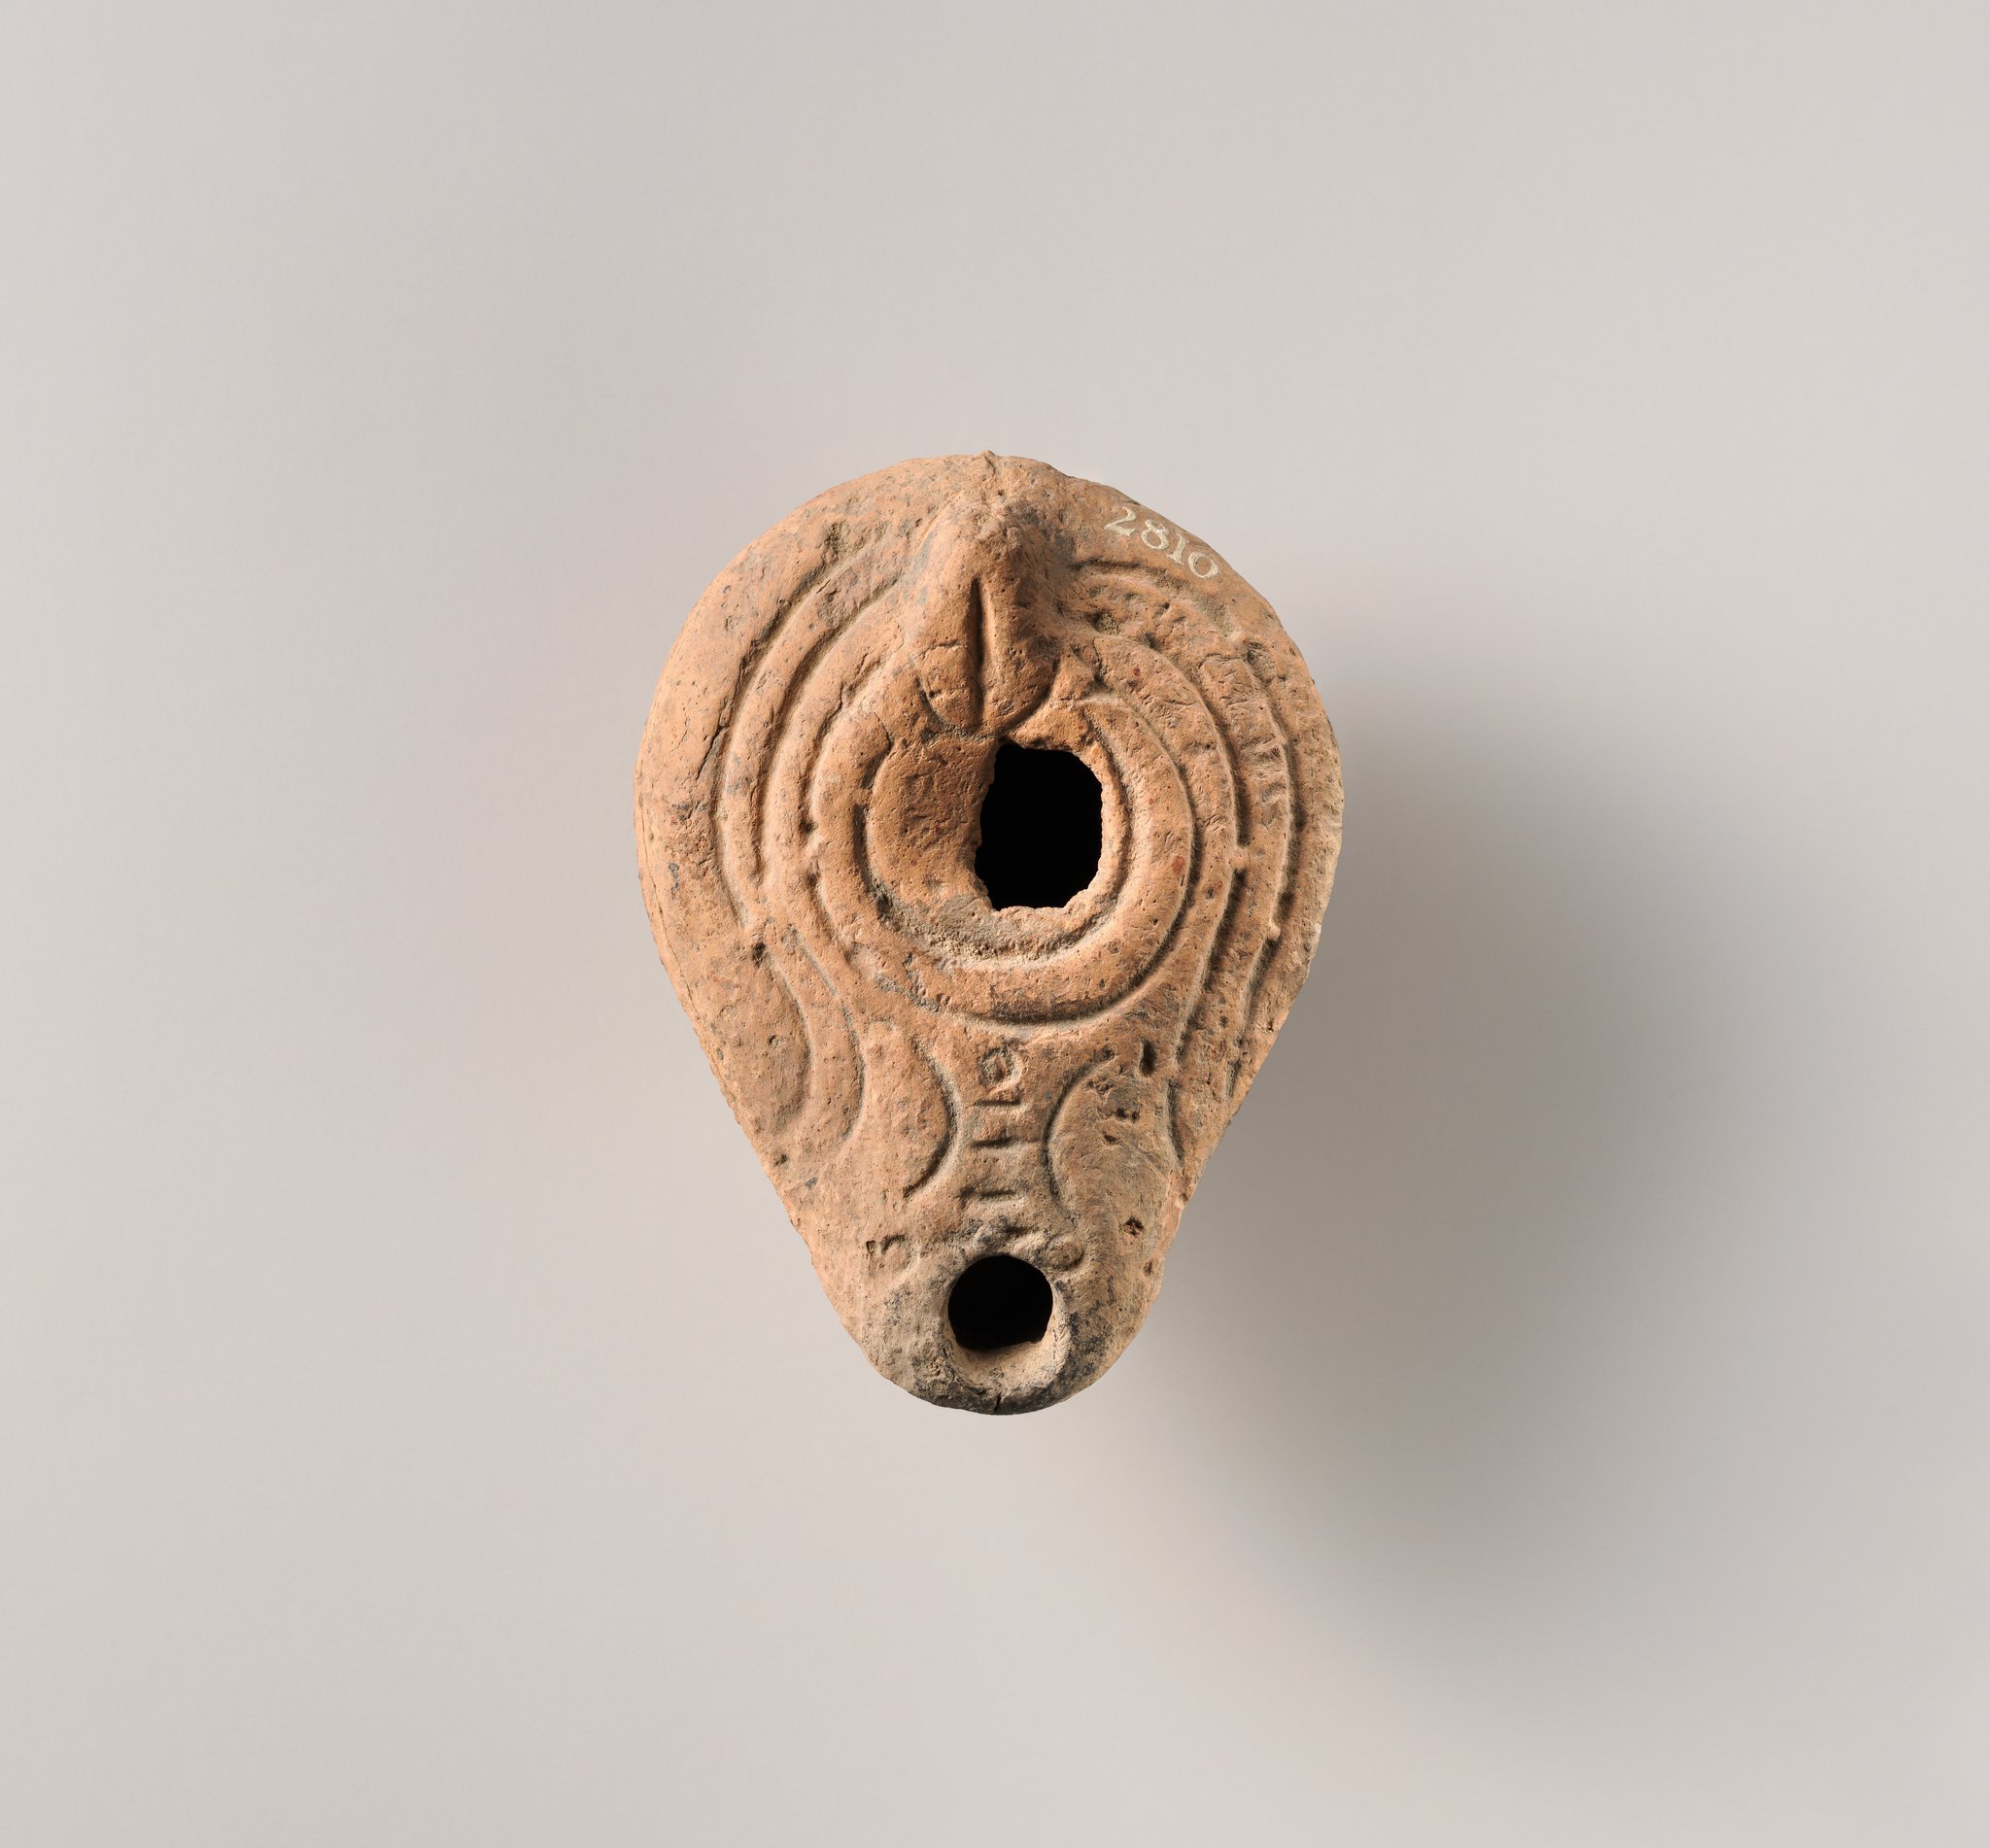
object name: lamp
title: Terracotta oil lamp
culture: roman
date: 201-300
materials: terracotta